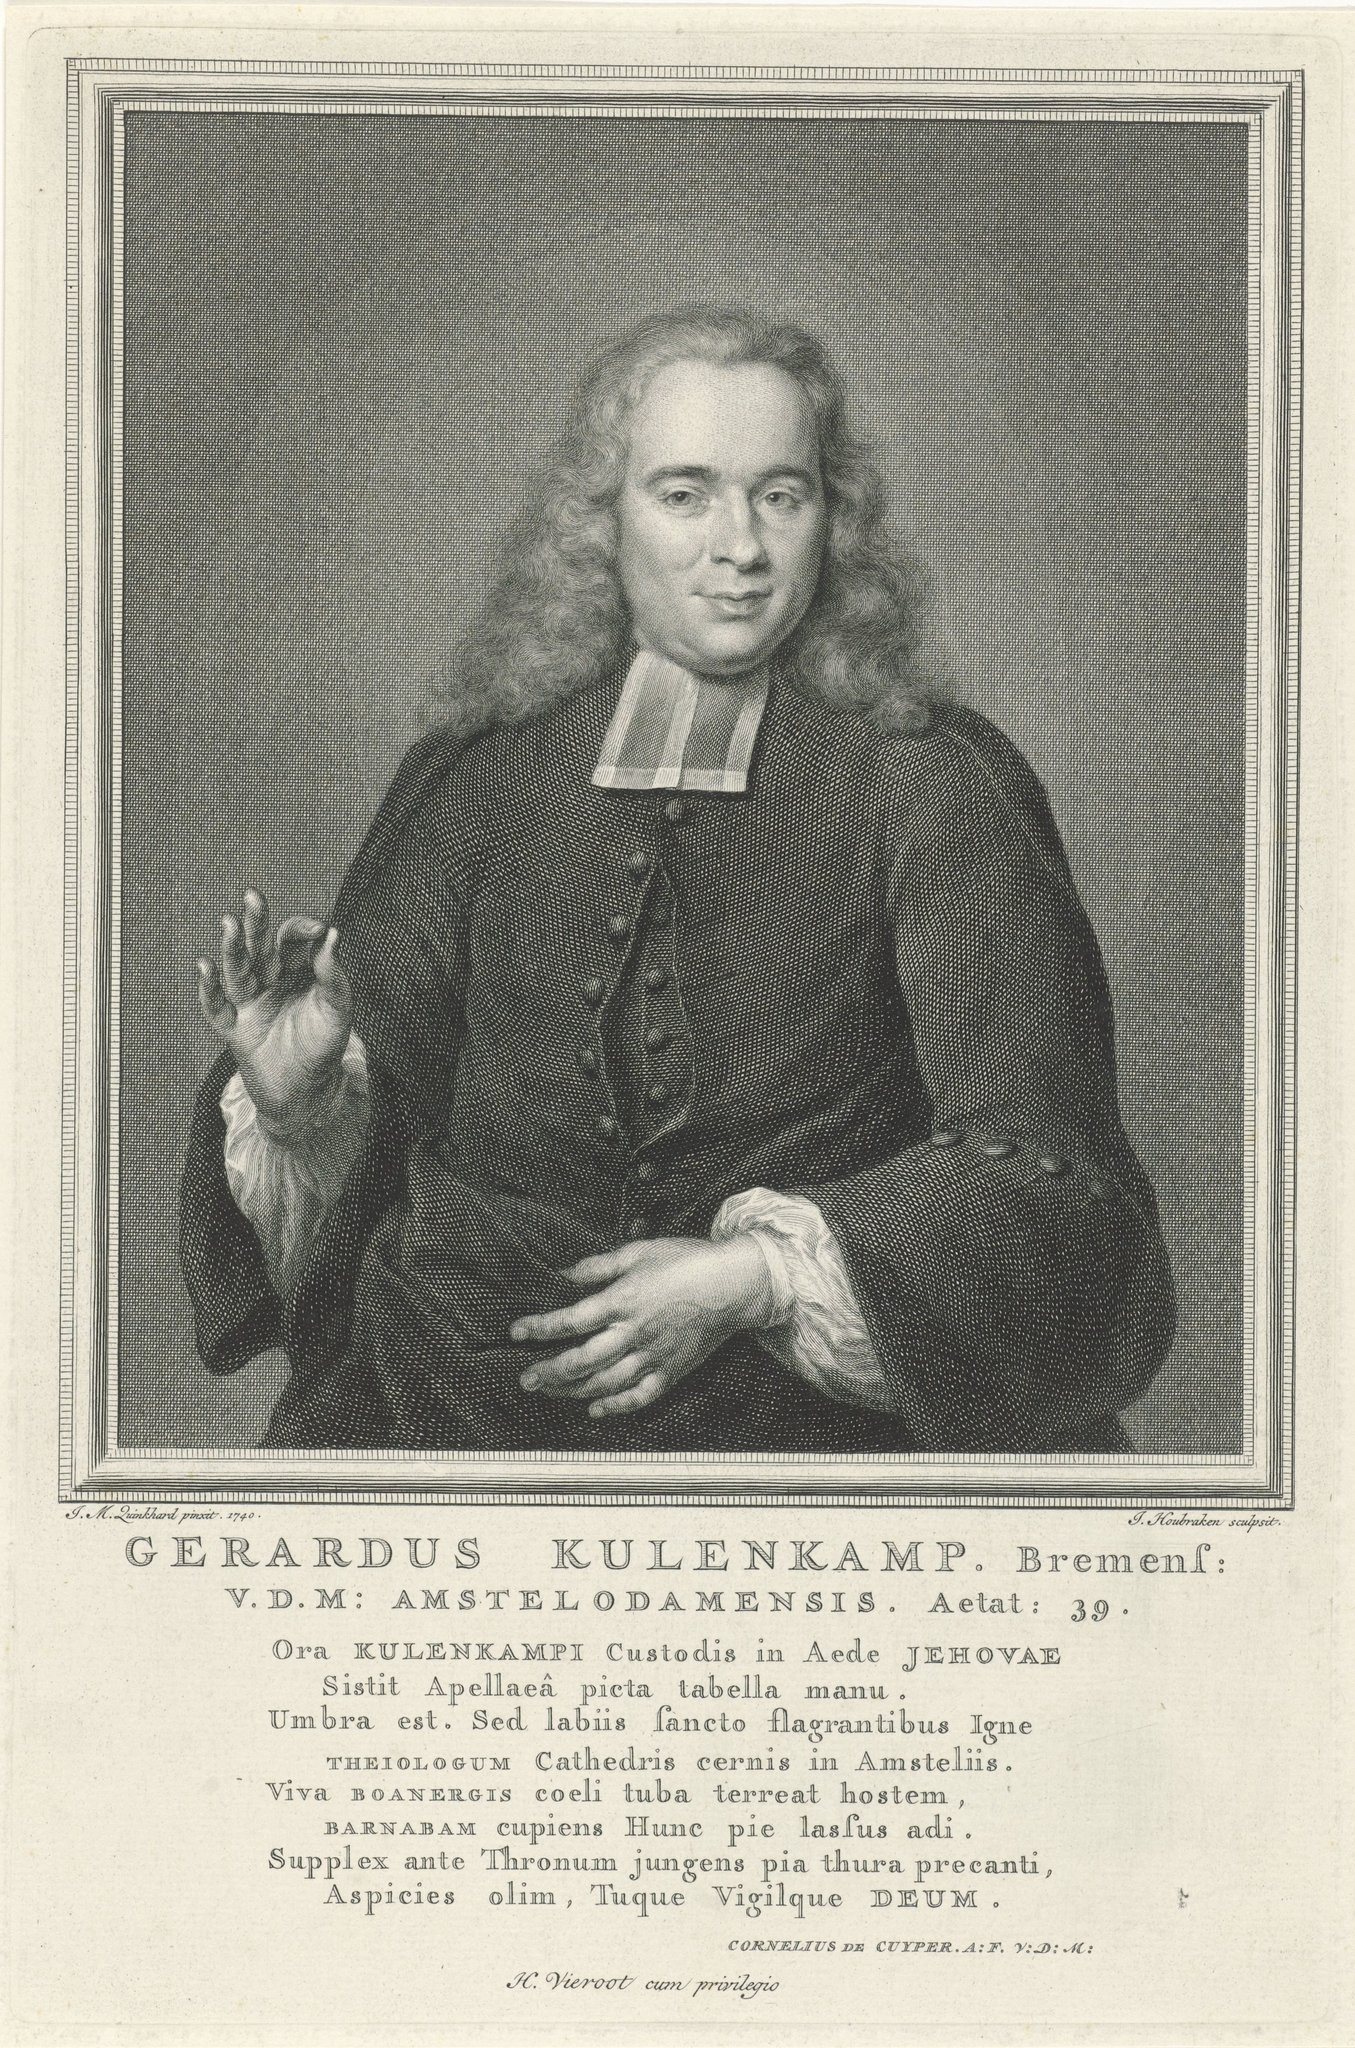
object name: print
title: Gerardus Kulenkamp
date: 1740-1775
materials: paper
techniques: engraving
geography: amsterdam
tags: bremen, predikant, gerardus kulenkamp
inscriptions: collector's mark: Lugt 240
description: Portret ten halven lijve van Gerardus Kulenkamp op 39-jarige leeftijd. Onder het portret zijn naam en gegevens in twee regels in het Latijn en daaronder een achtregelige tekst in het Latijn.